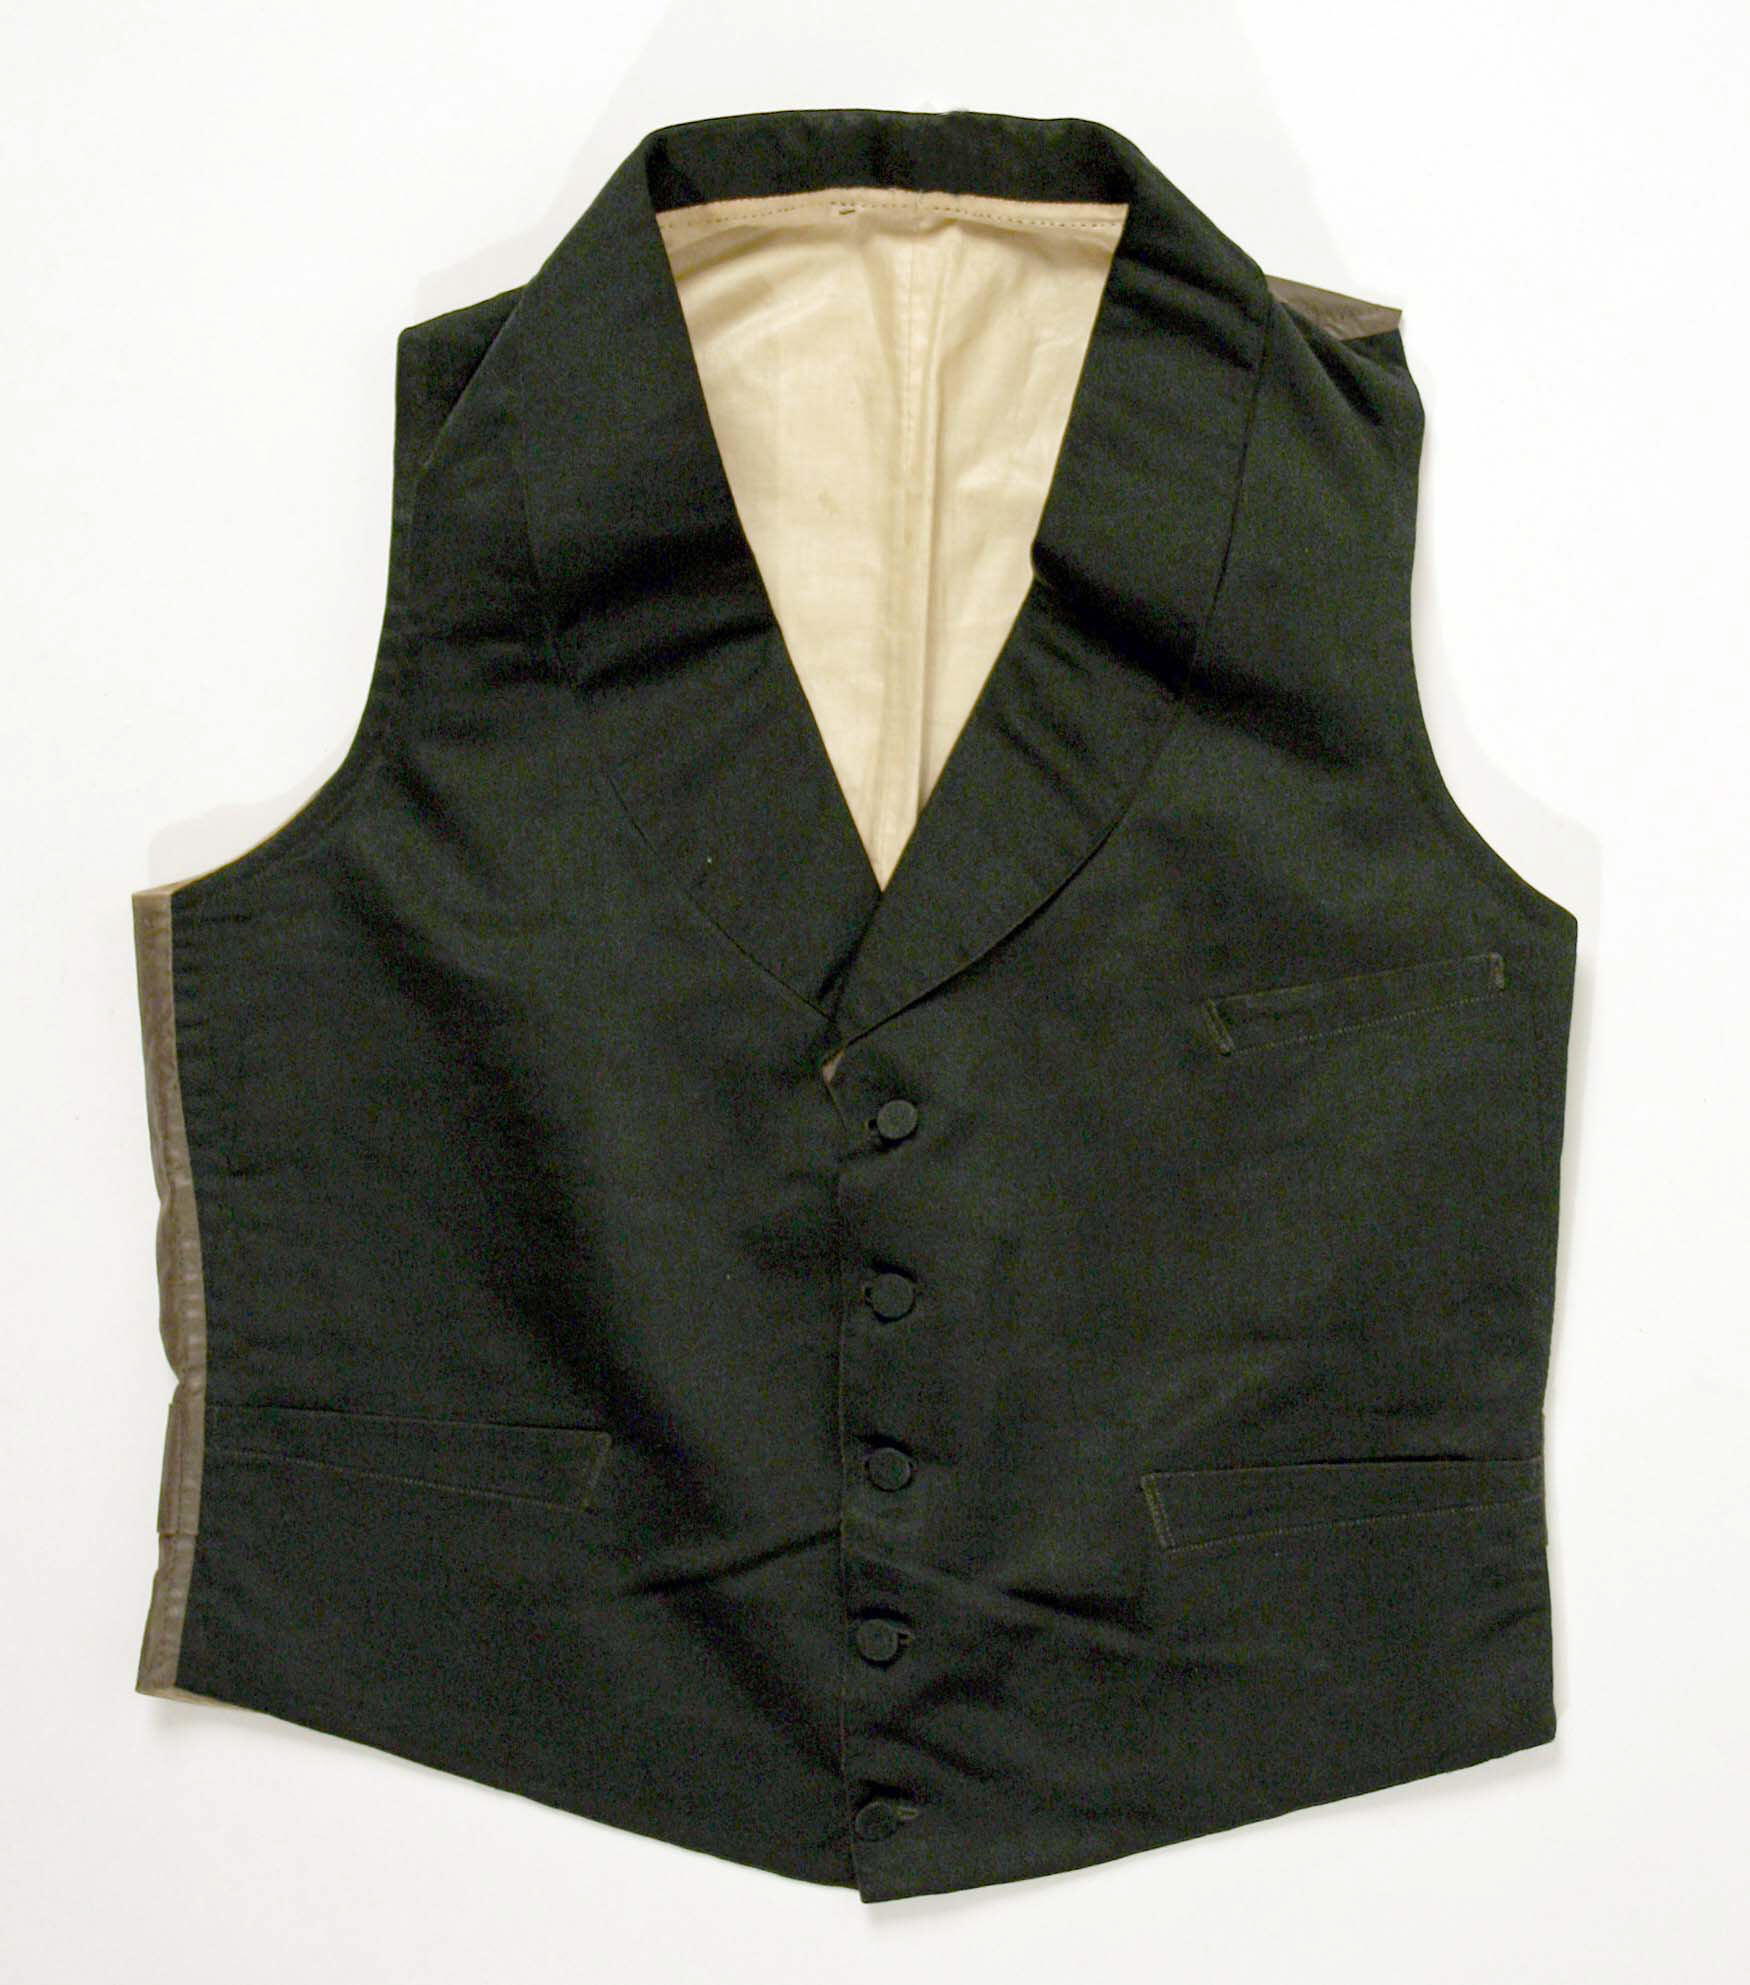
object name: waistcoat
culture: american or european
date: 1840-1859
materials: cotton, silk